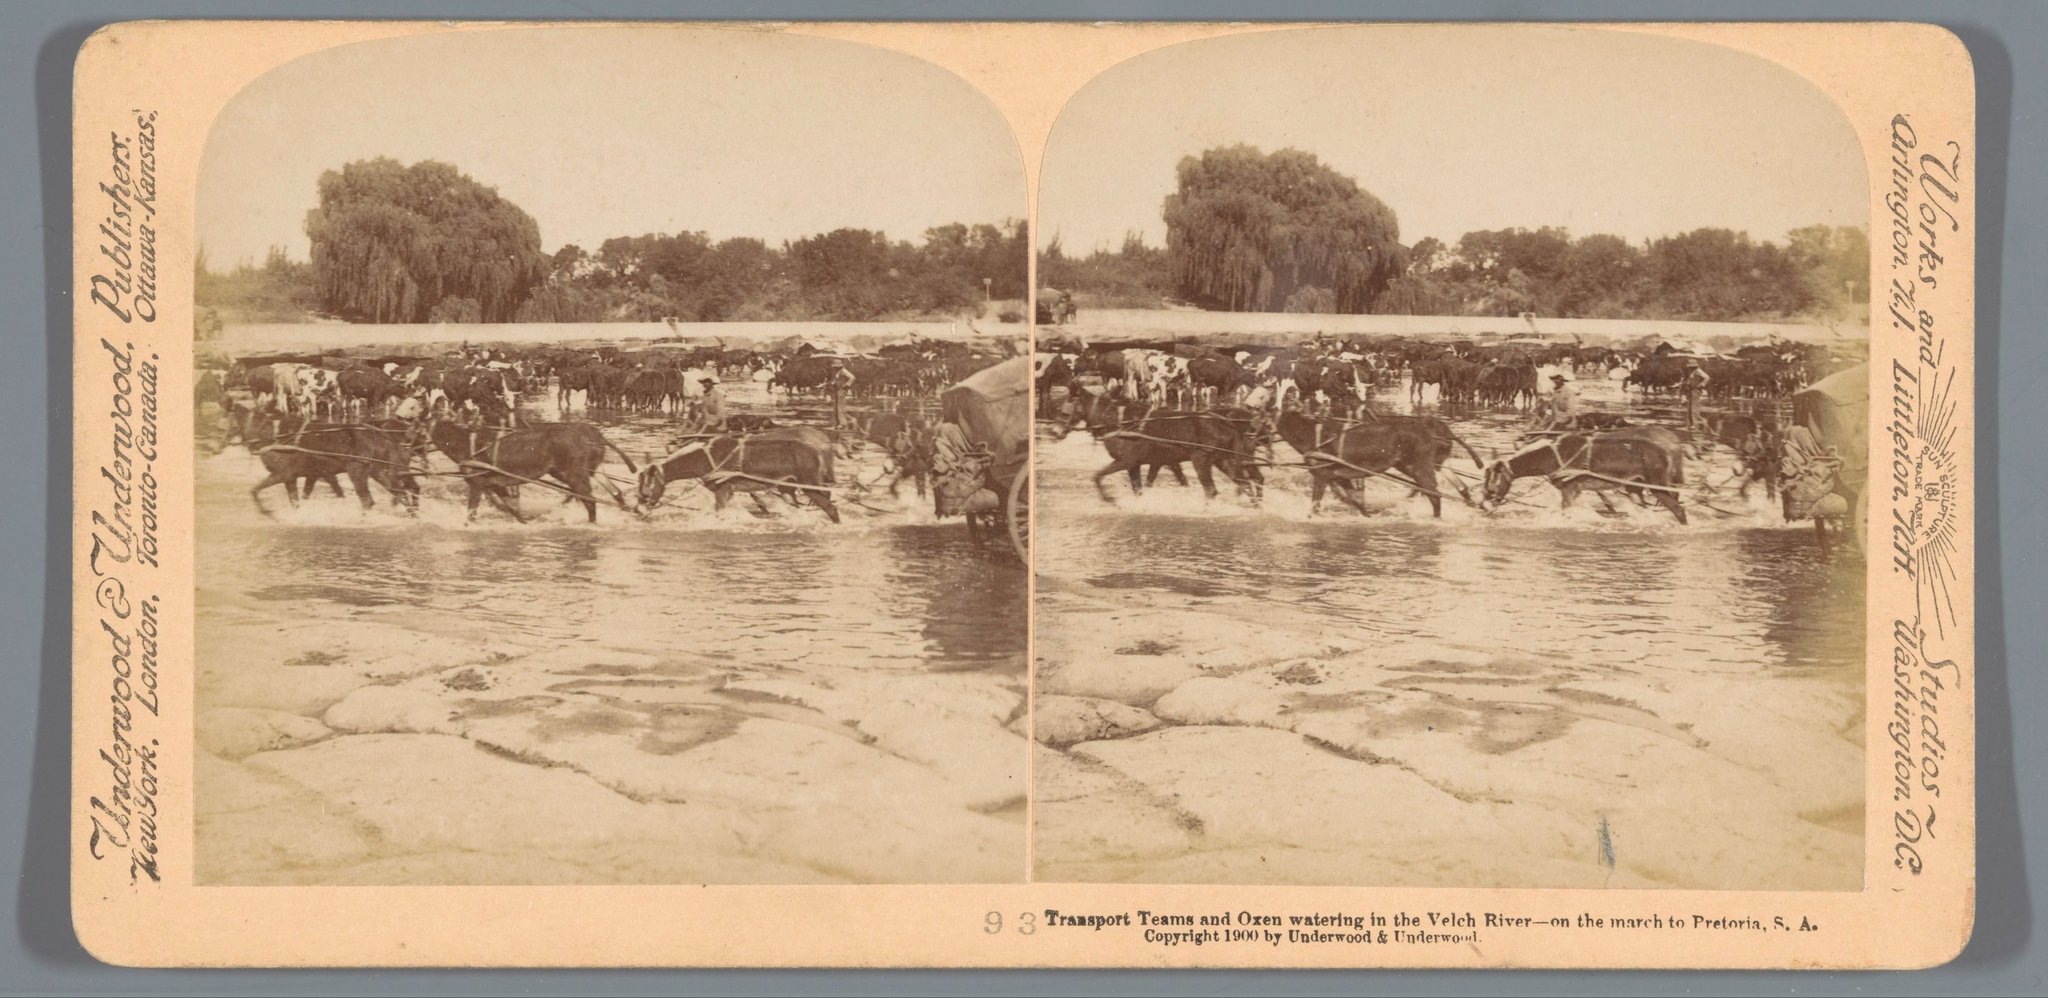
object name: stereograph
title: Transport Teams and Oxen watering in the Velch River - on the march to Pretoria, S.A.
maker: Anonymous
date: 1900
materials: cardboard, paper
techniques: albumen print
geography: new york city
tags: troop movements, transportation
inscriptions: number: ‘93’, inscription: ‘Works and Studios ~/ Arlington, N.J. Littleton, N.H. Washington, D.C.’, copyright notice: ‘Copyright 1900 by Underwood & Underwood.’, inscription